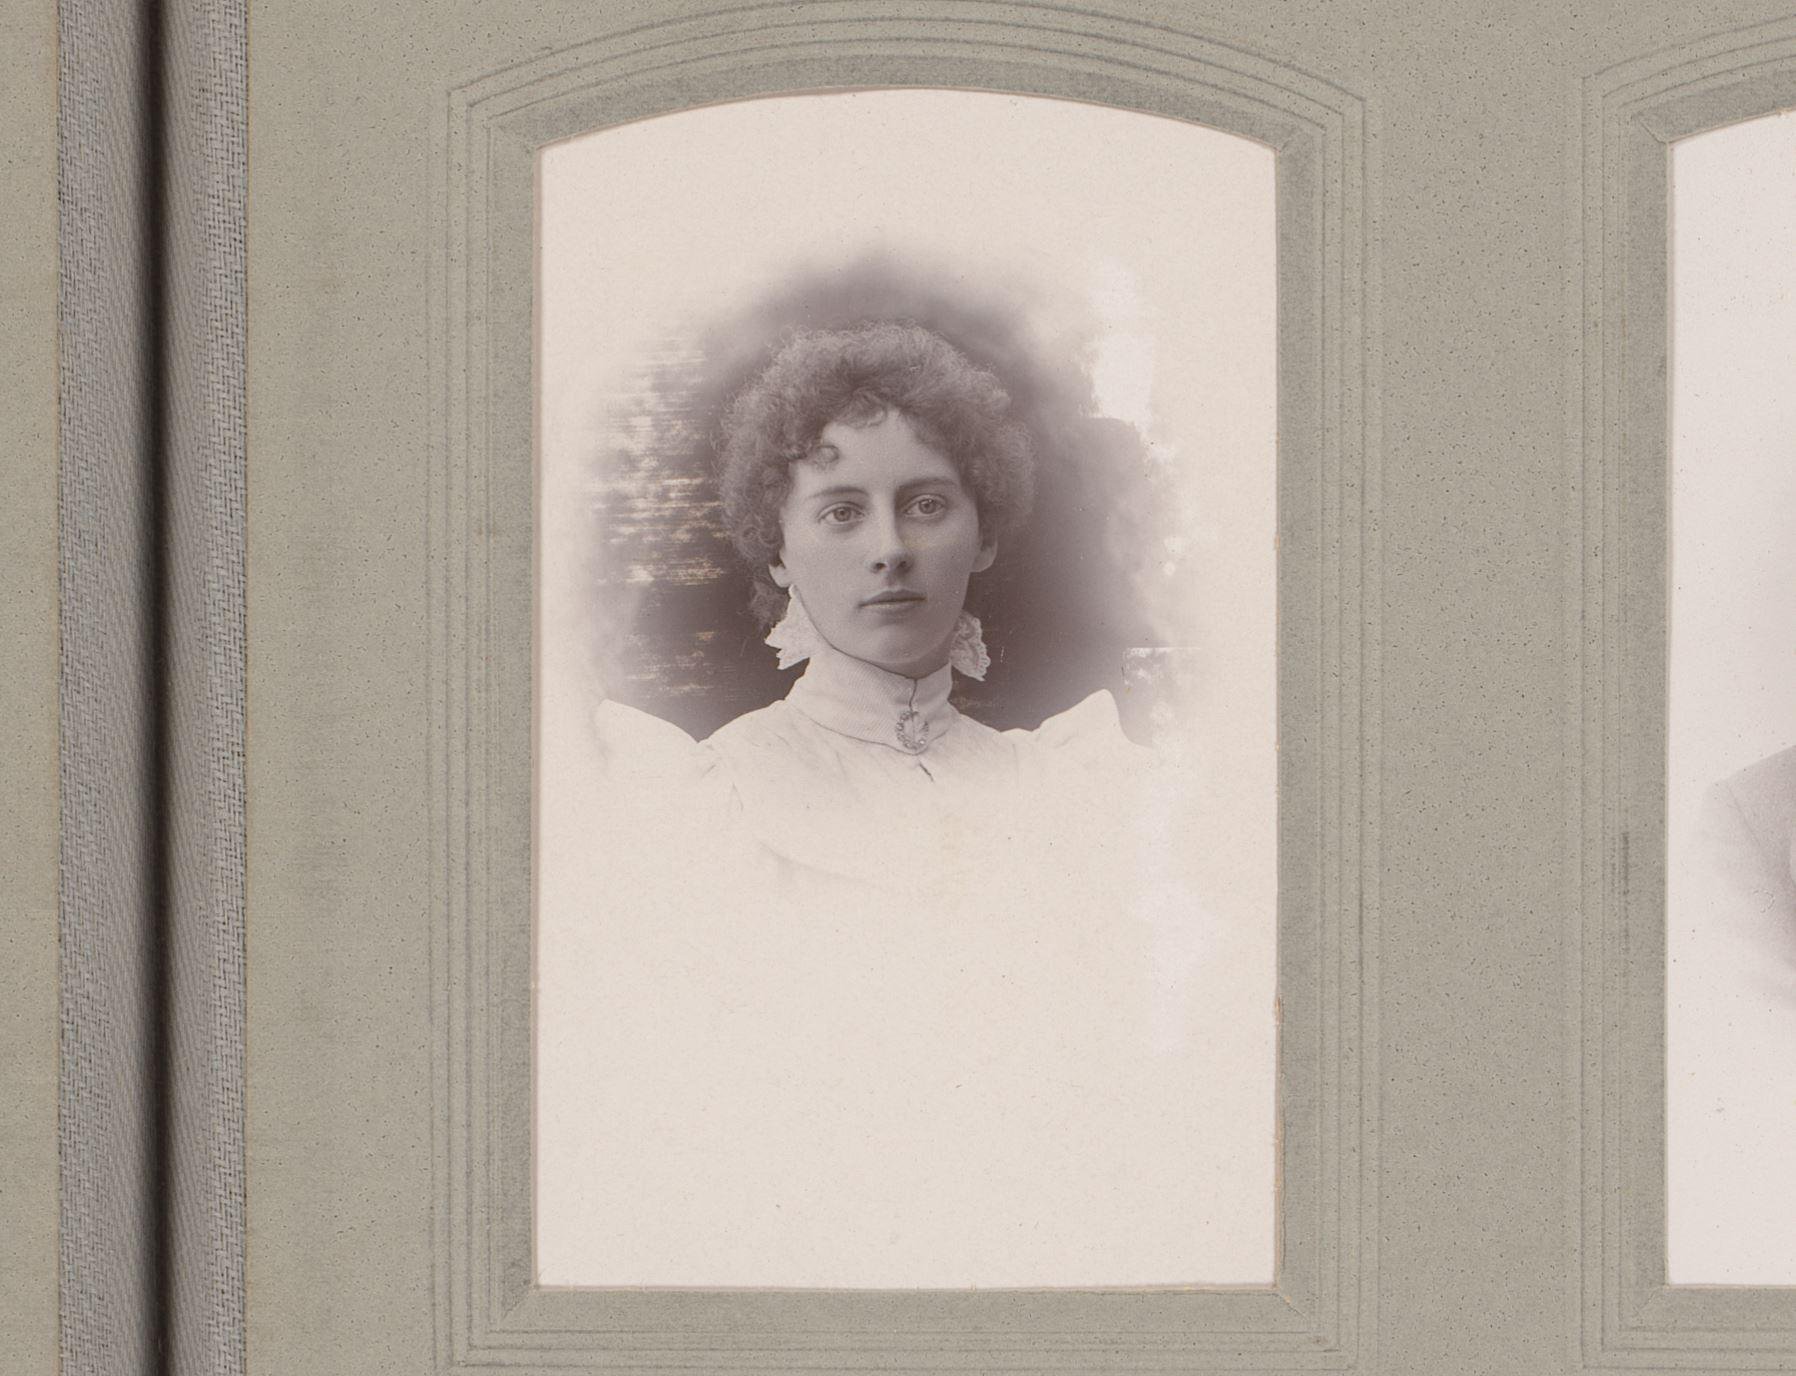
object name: album leaf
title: Portret van een vrouw in hooggesloten jurk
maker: hildur björklind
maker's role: fotograaf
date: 1880-1920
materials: cardboard, photographic support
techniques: collodion silver print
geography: sundsvall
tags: historical persons - bb - woman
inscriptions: inscription: ‘Hildur Björklind/ Sundsvall/ Sjögatan 7./ Samma hus som Skeppsbrokällaren./ Plåten förvaras för Efterbeställning.’